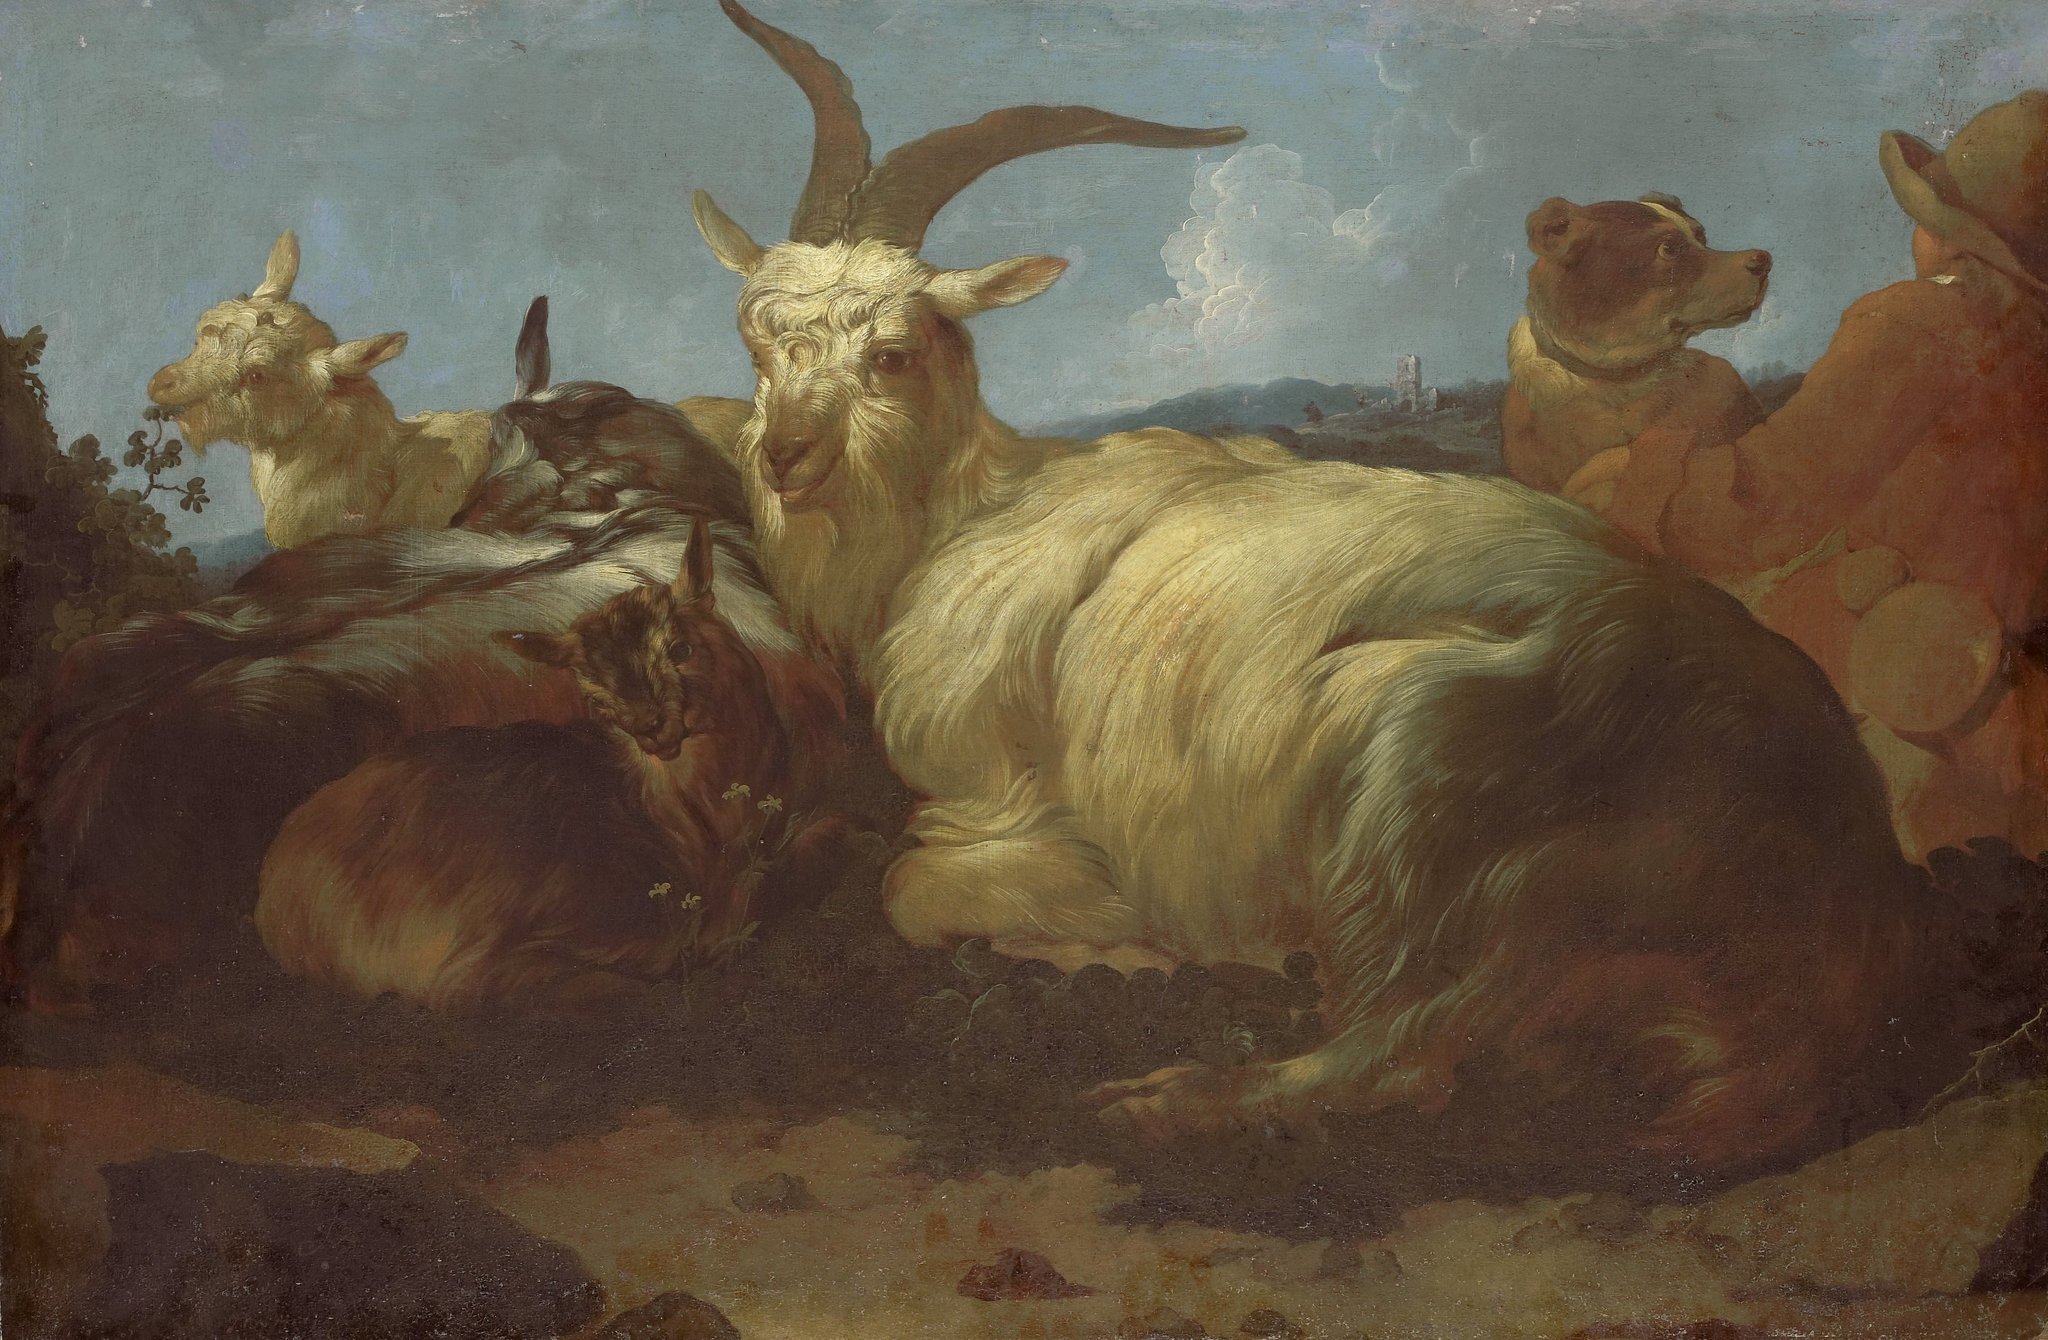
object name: painting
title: A Goatherd Watching his Animals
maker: johann melchior roos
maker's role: painter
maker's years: 1663-1731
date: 1683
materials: canvas, oil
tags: herding, herdsman, herdswoman, shepherd, shepherdess, cowherd, etc., goat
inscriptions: signature and date: ‘JMRoos fecit 1683’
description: Liggende bok en geiten, rechts een herder met zijn hond.